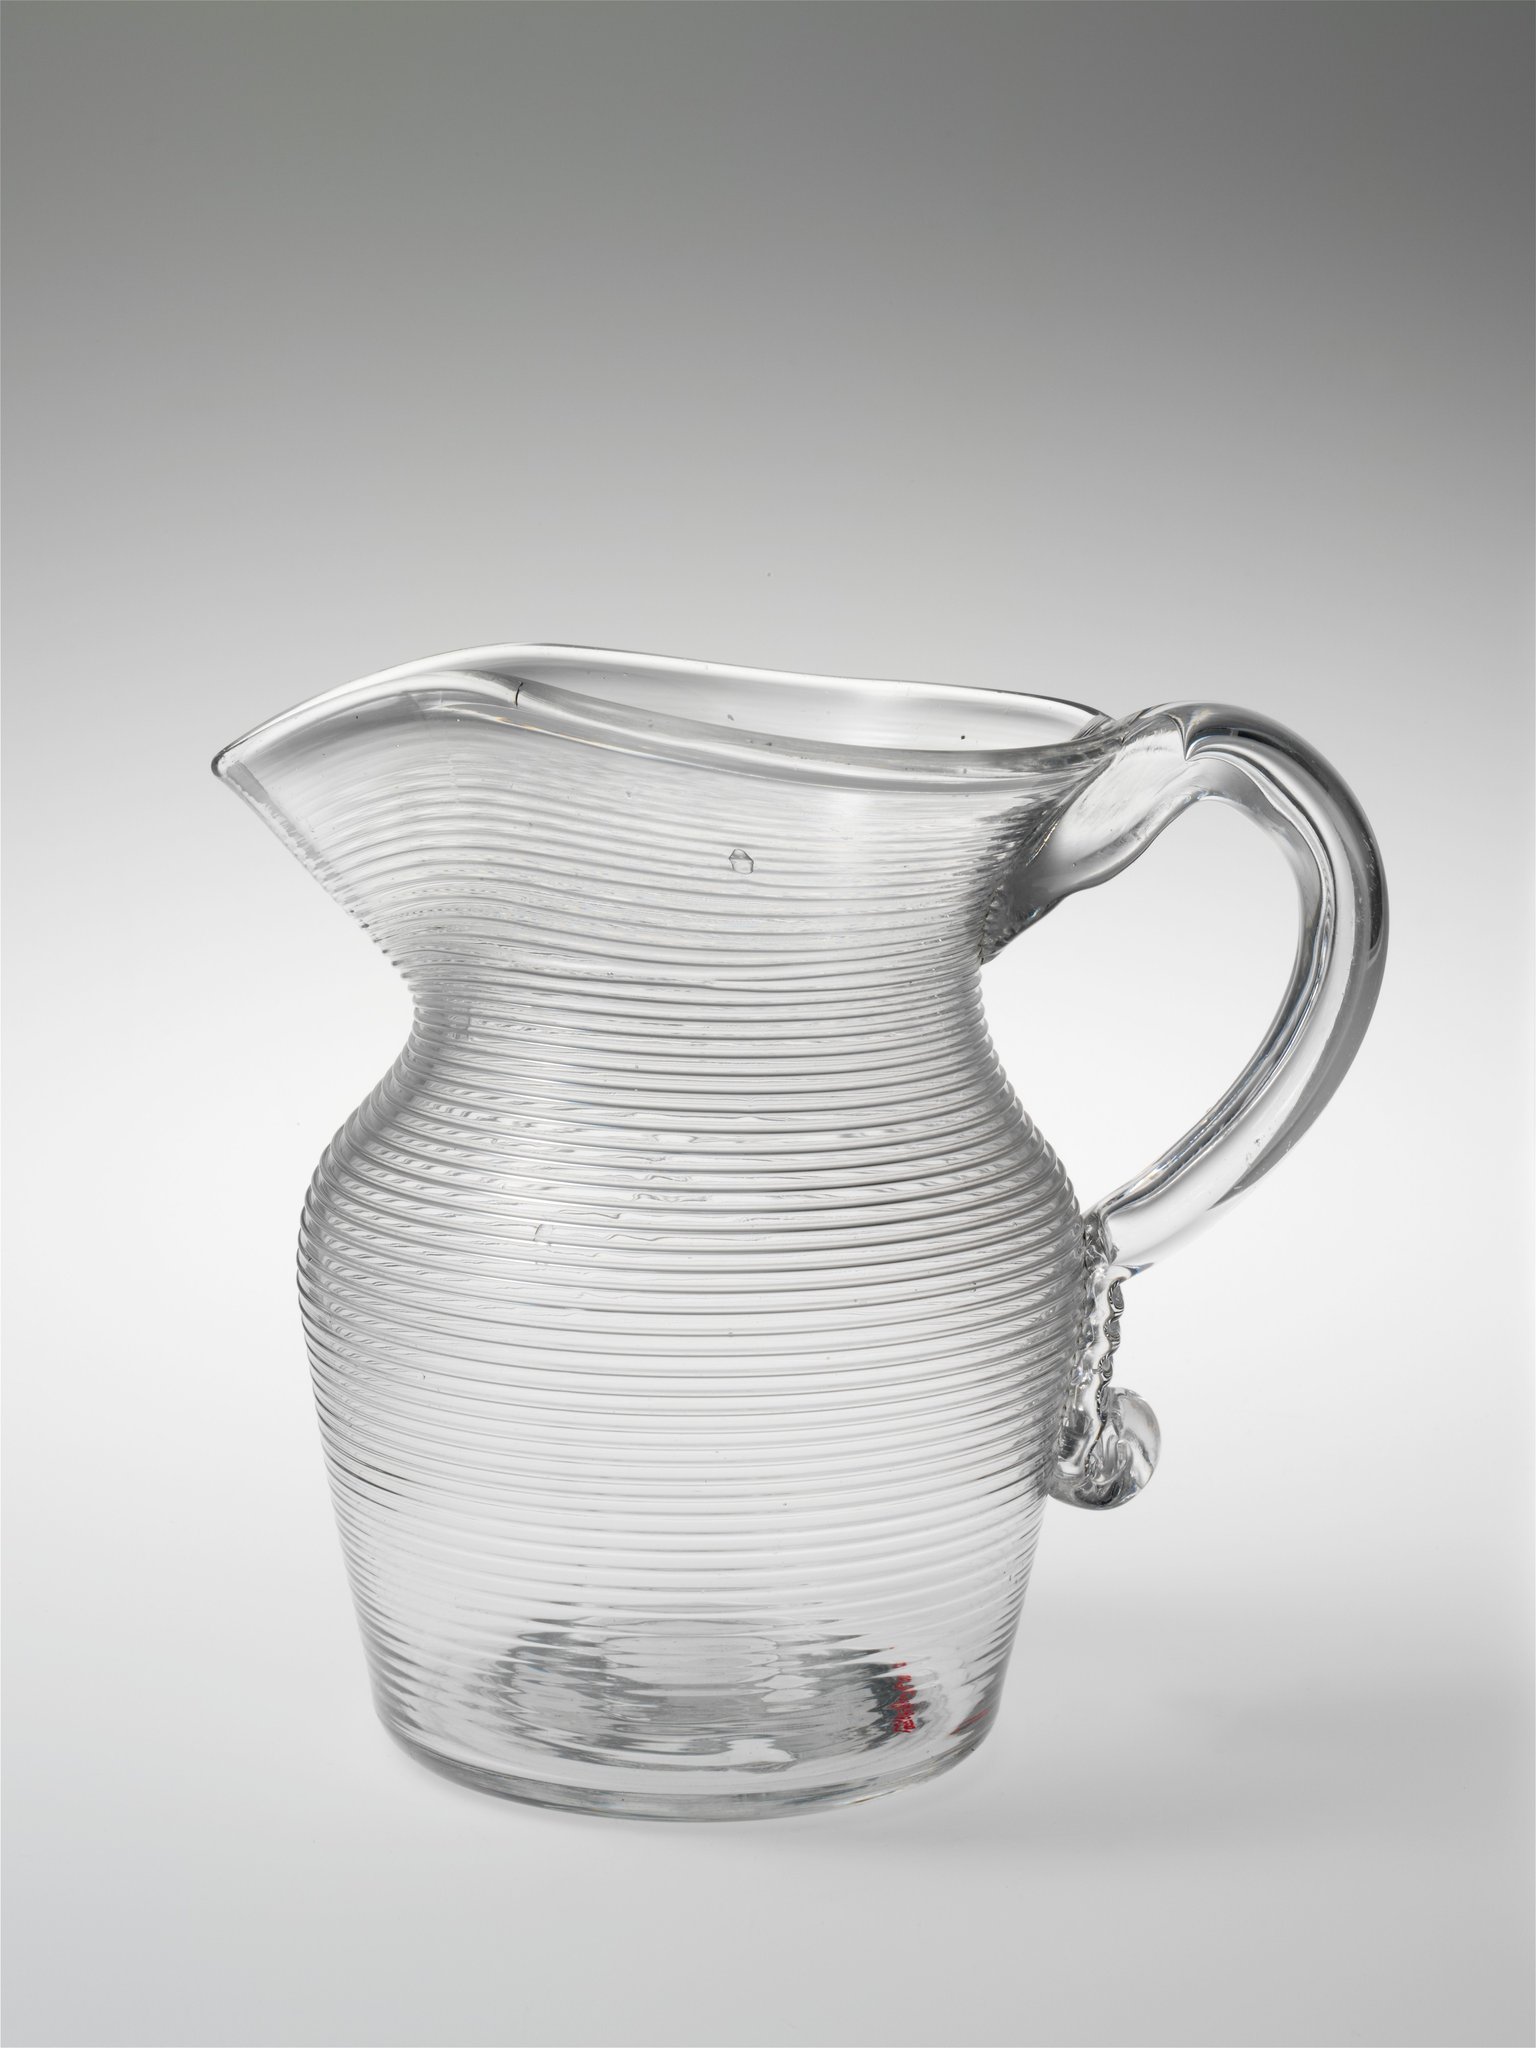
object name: pitcher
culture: american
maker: boston & sandwich glass company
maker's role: maker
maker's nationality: american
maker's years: 1825-1888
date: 1850-1875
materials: glass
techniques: glassblowing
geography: united states